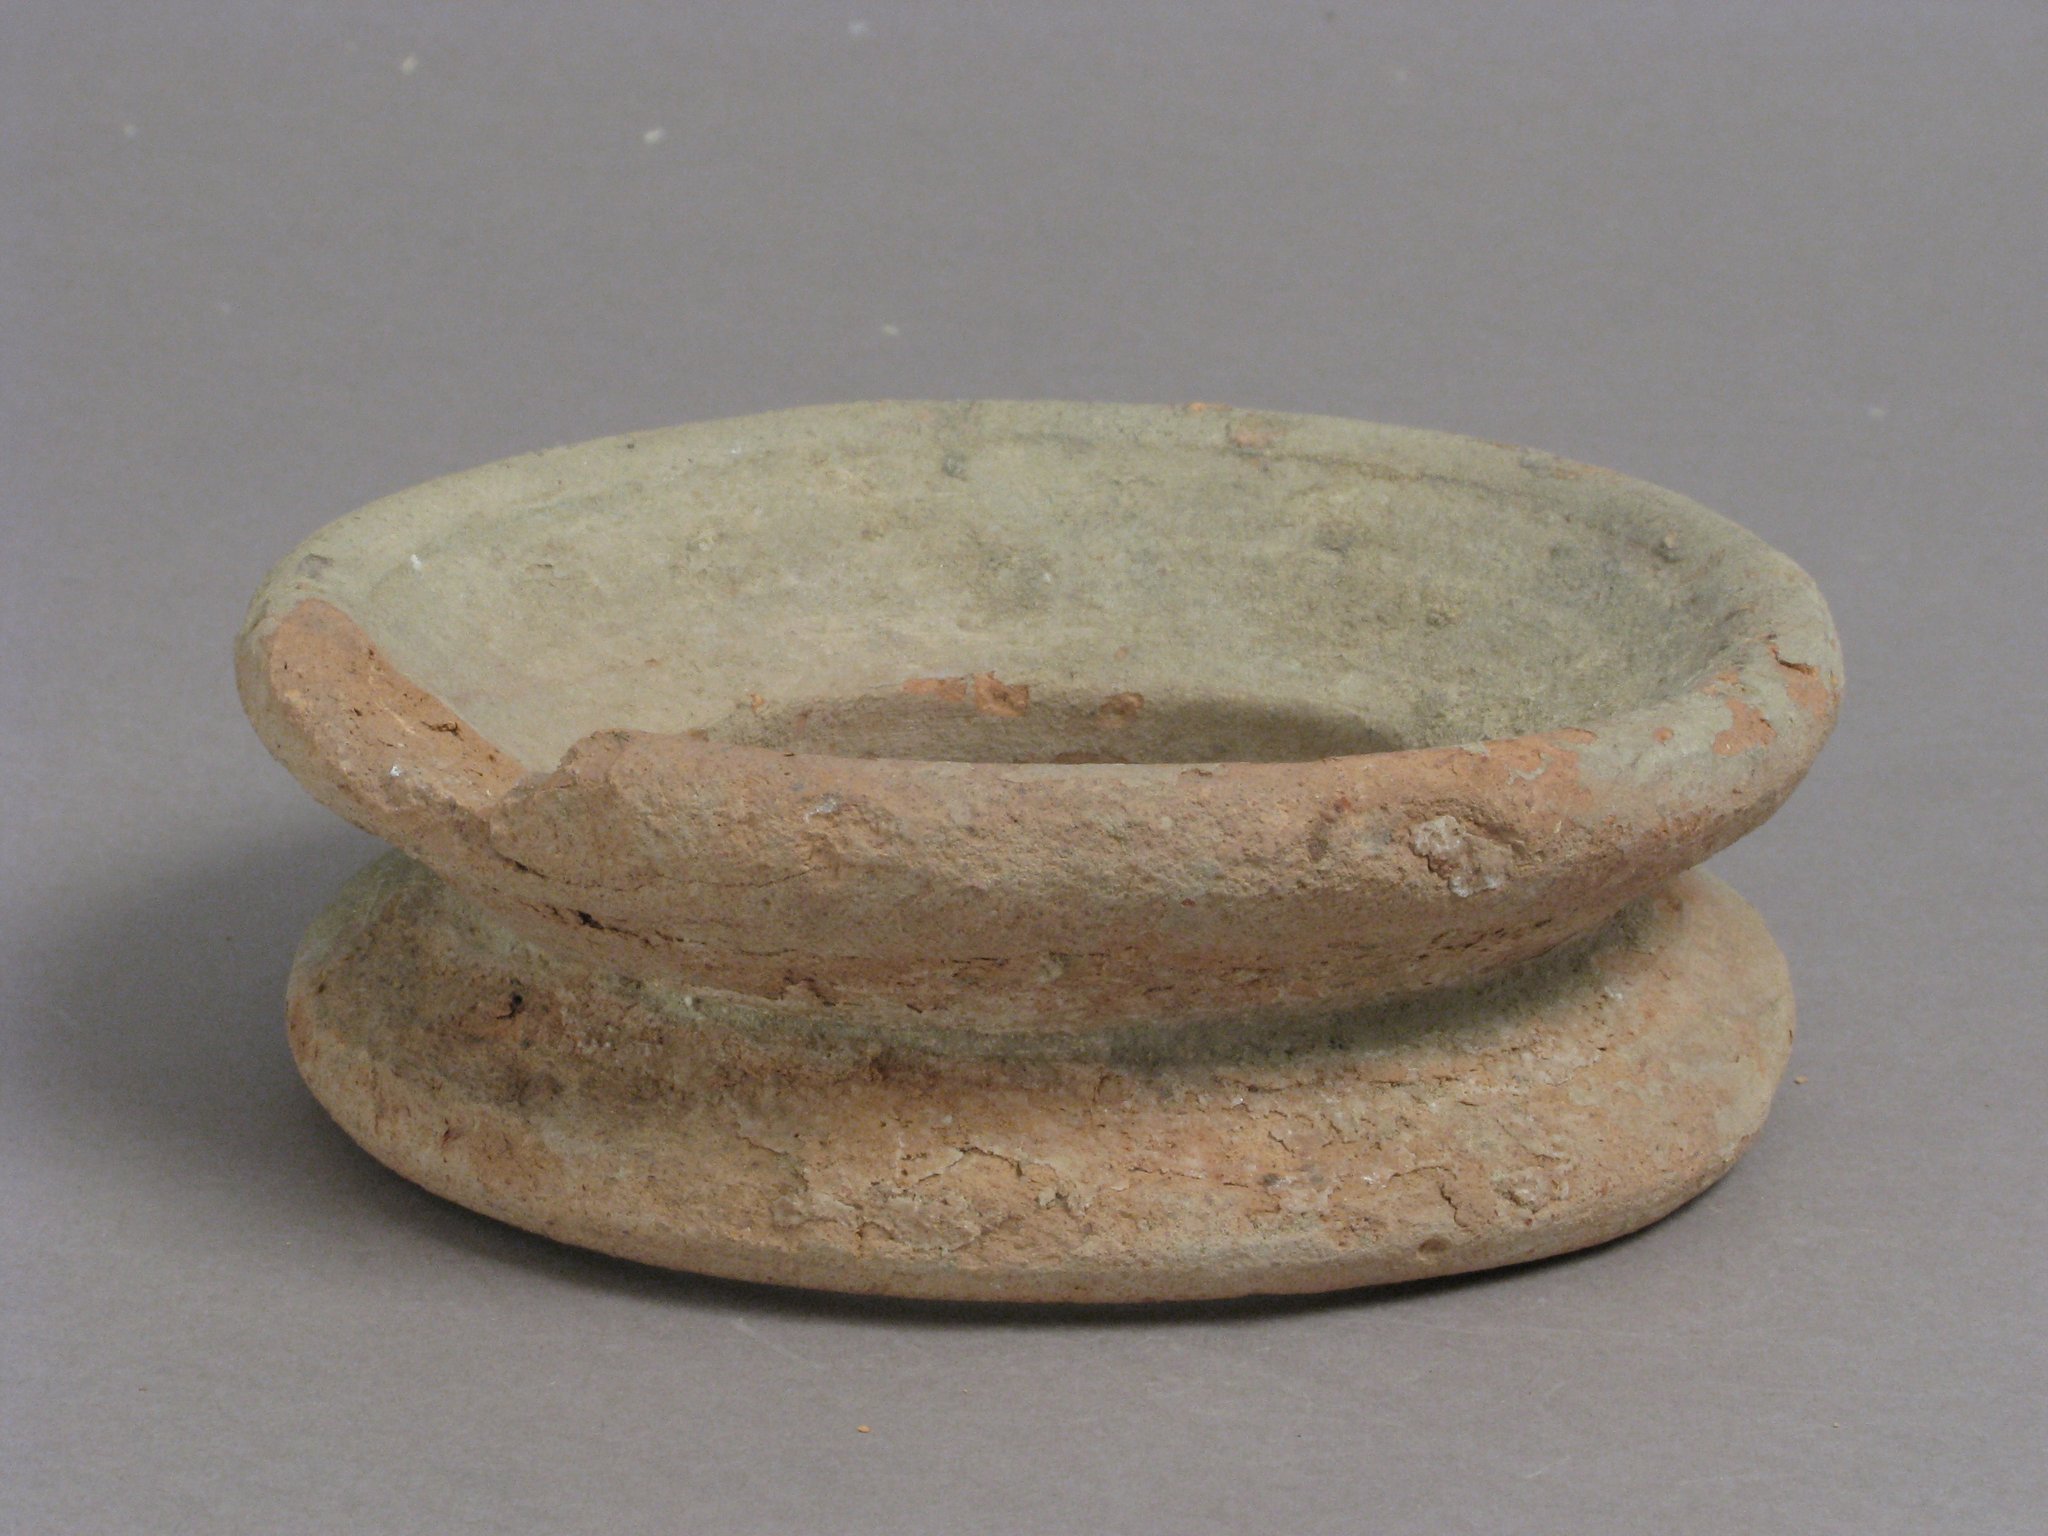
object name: ring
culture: coptic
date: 301-700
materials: earthenware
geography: egypt